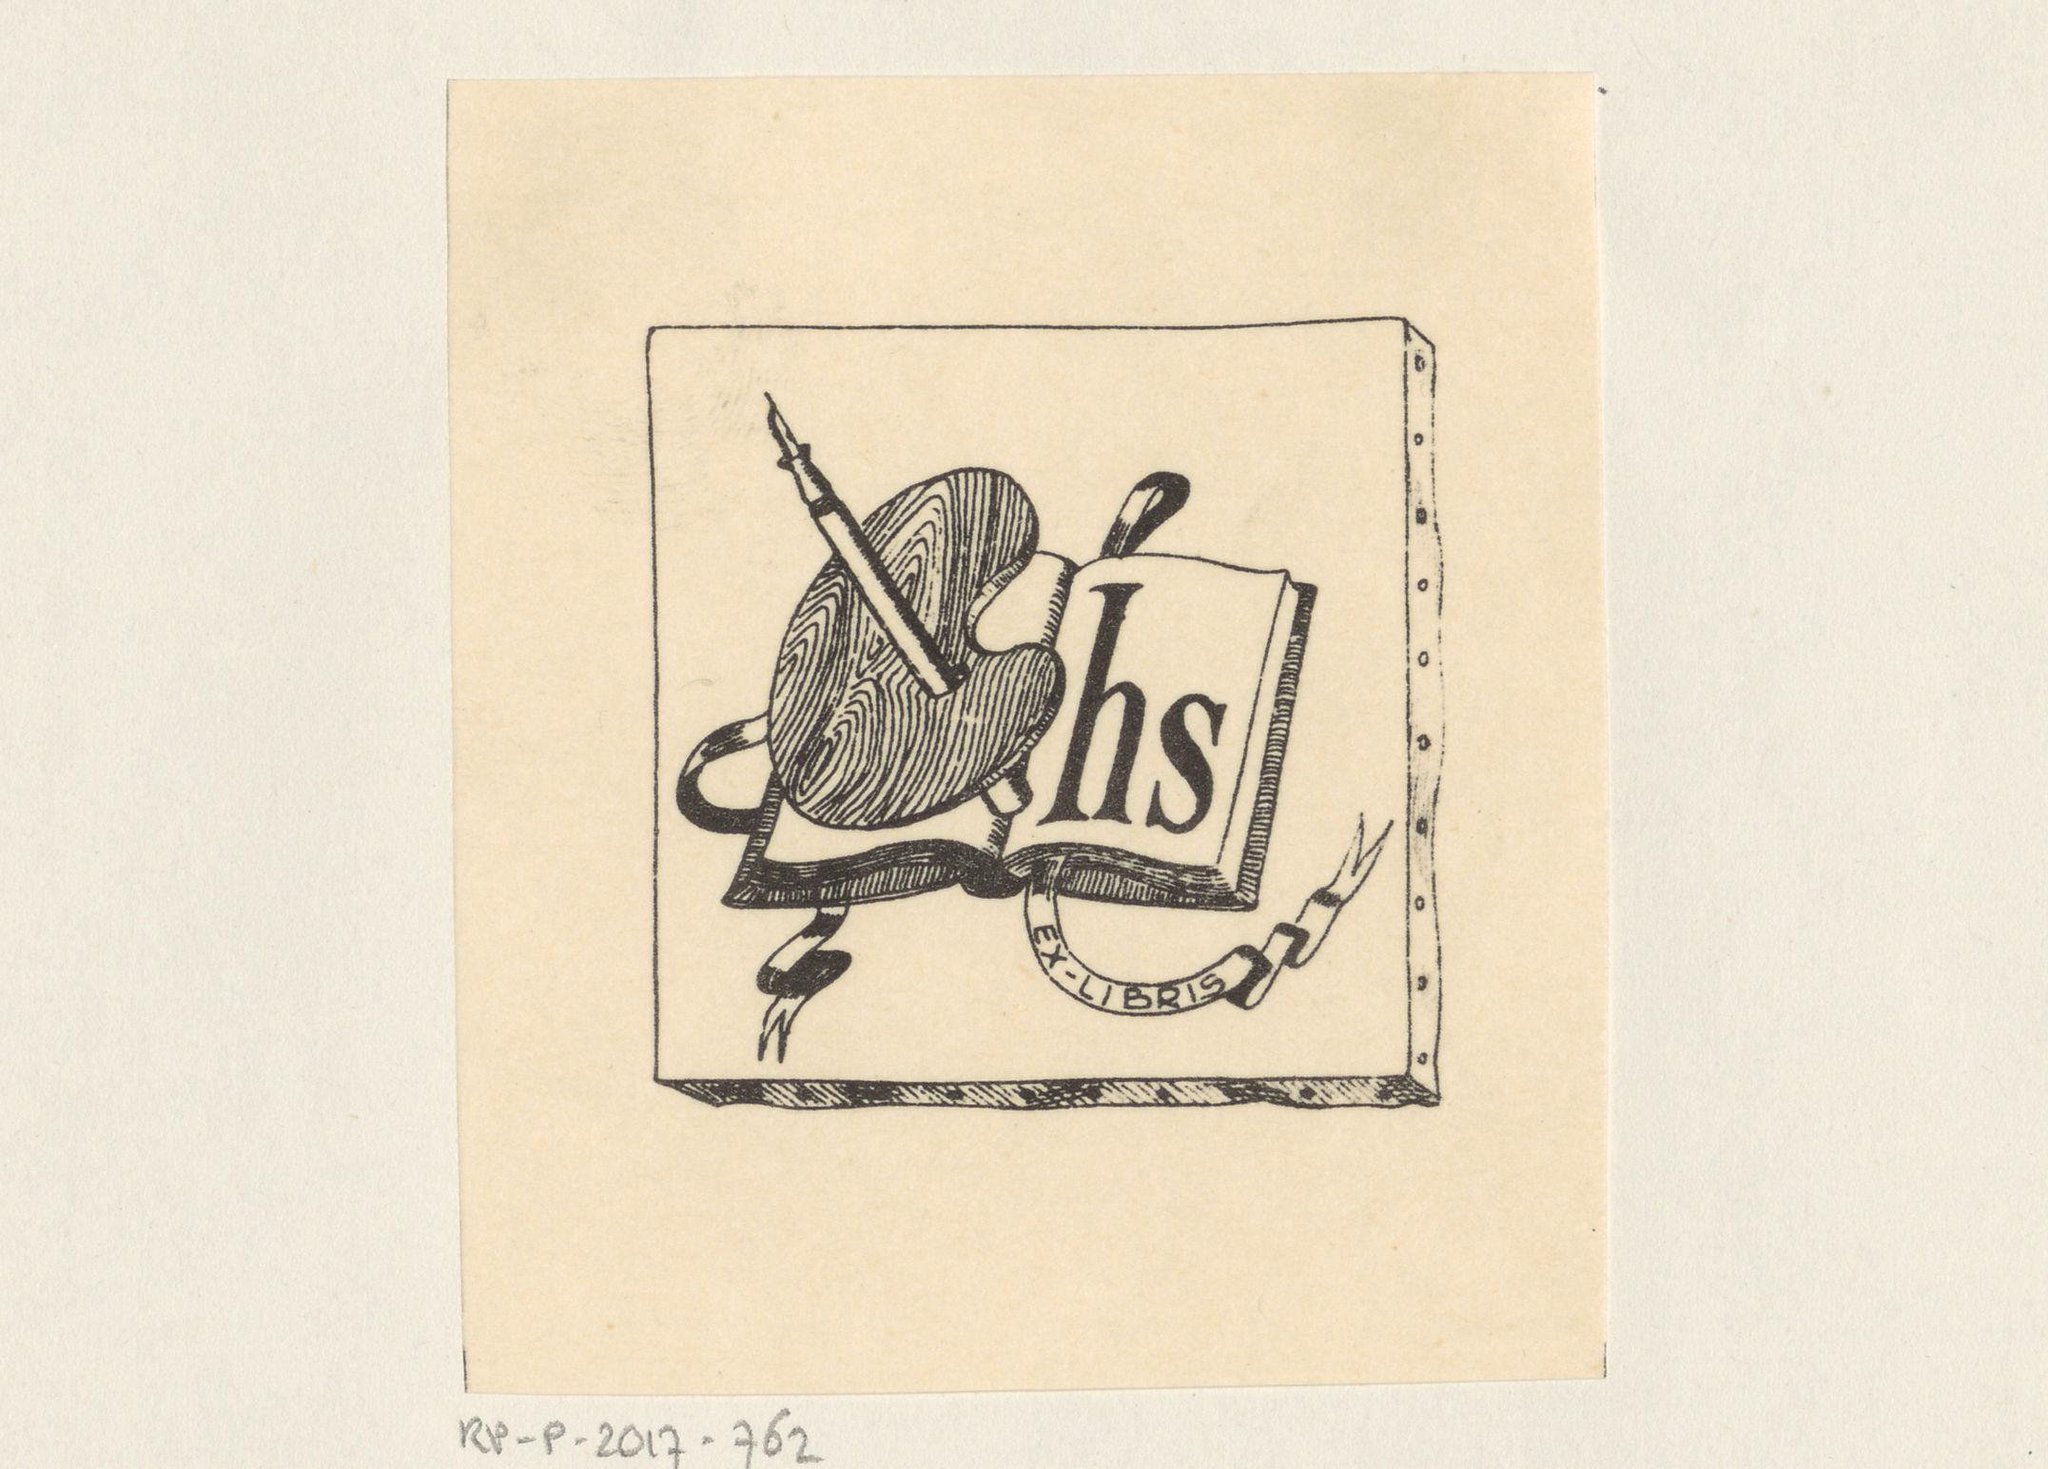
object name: bookplate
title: Ex libris van H.S.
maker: Anonymous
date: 1900-1999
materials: paper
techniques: printing block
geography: netherlands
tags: tools, implements of painter, book